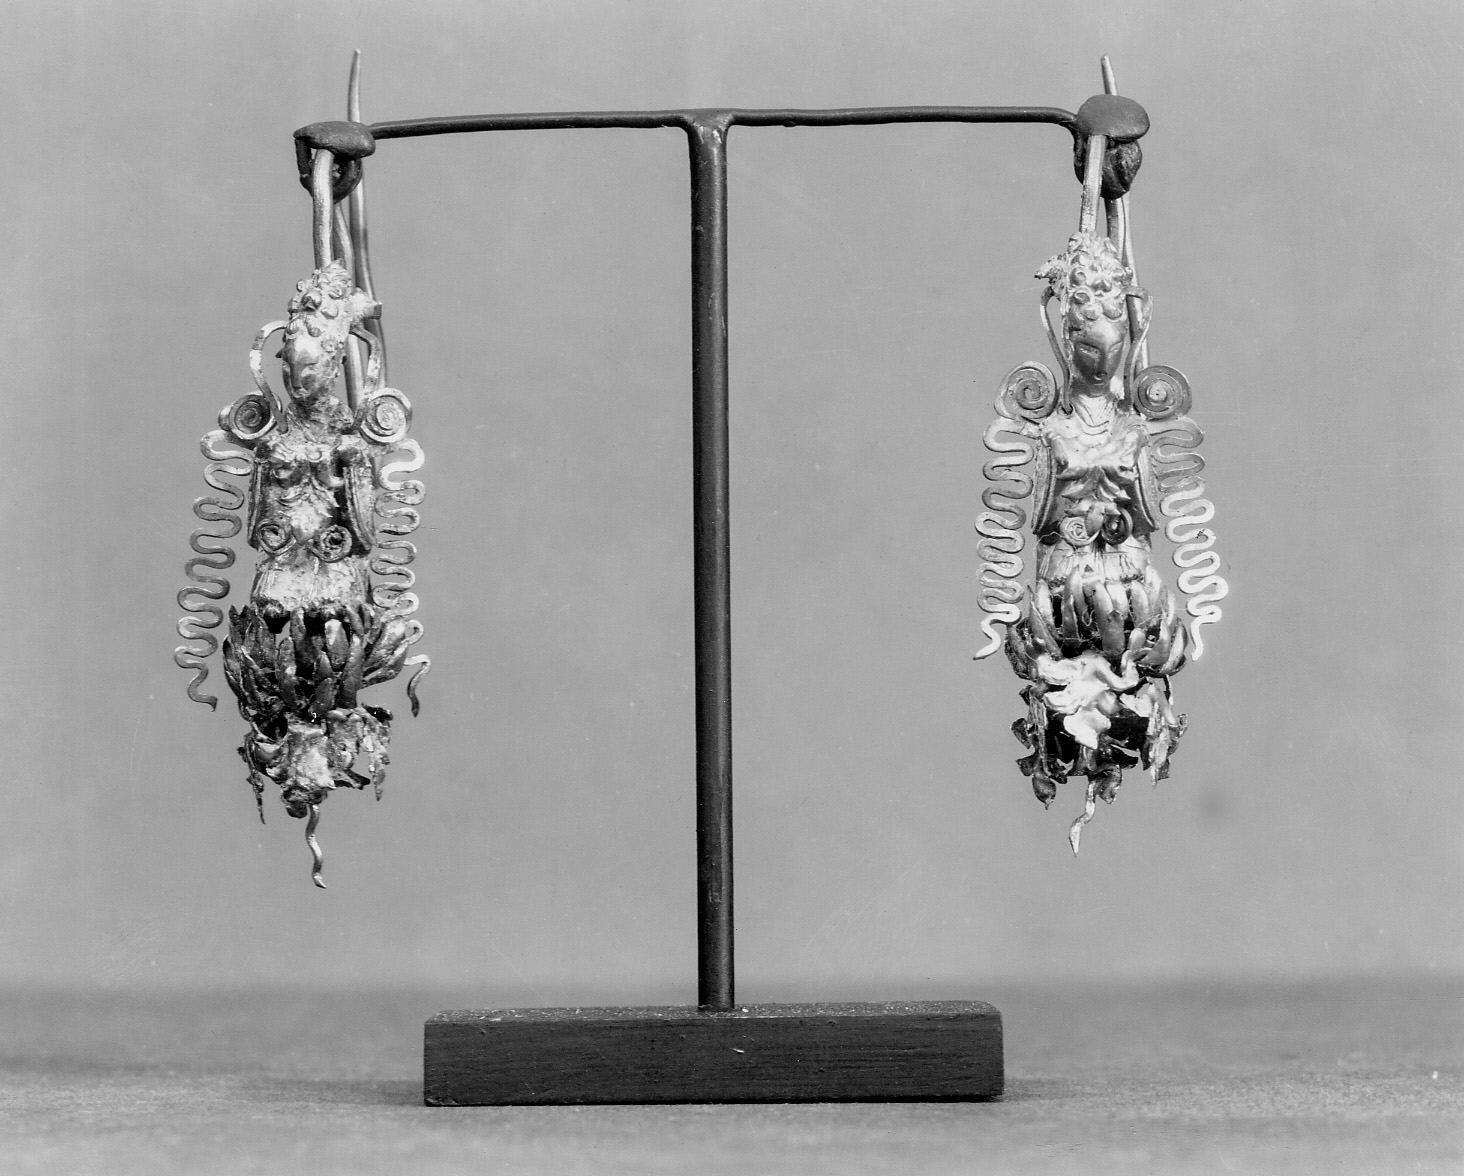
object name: pair of earring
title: Pair of Earrings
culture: chinese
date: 618-907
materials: gold